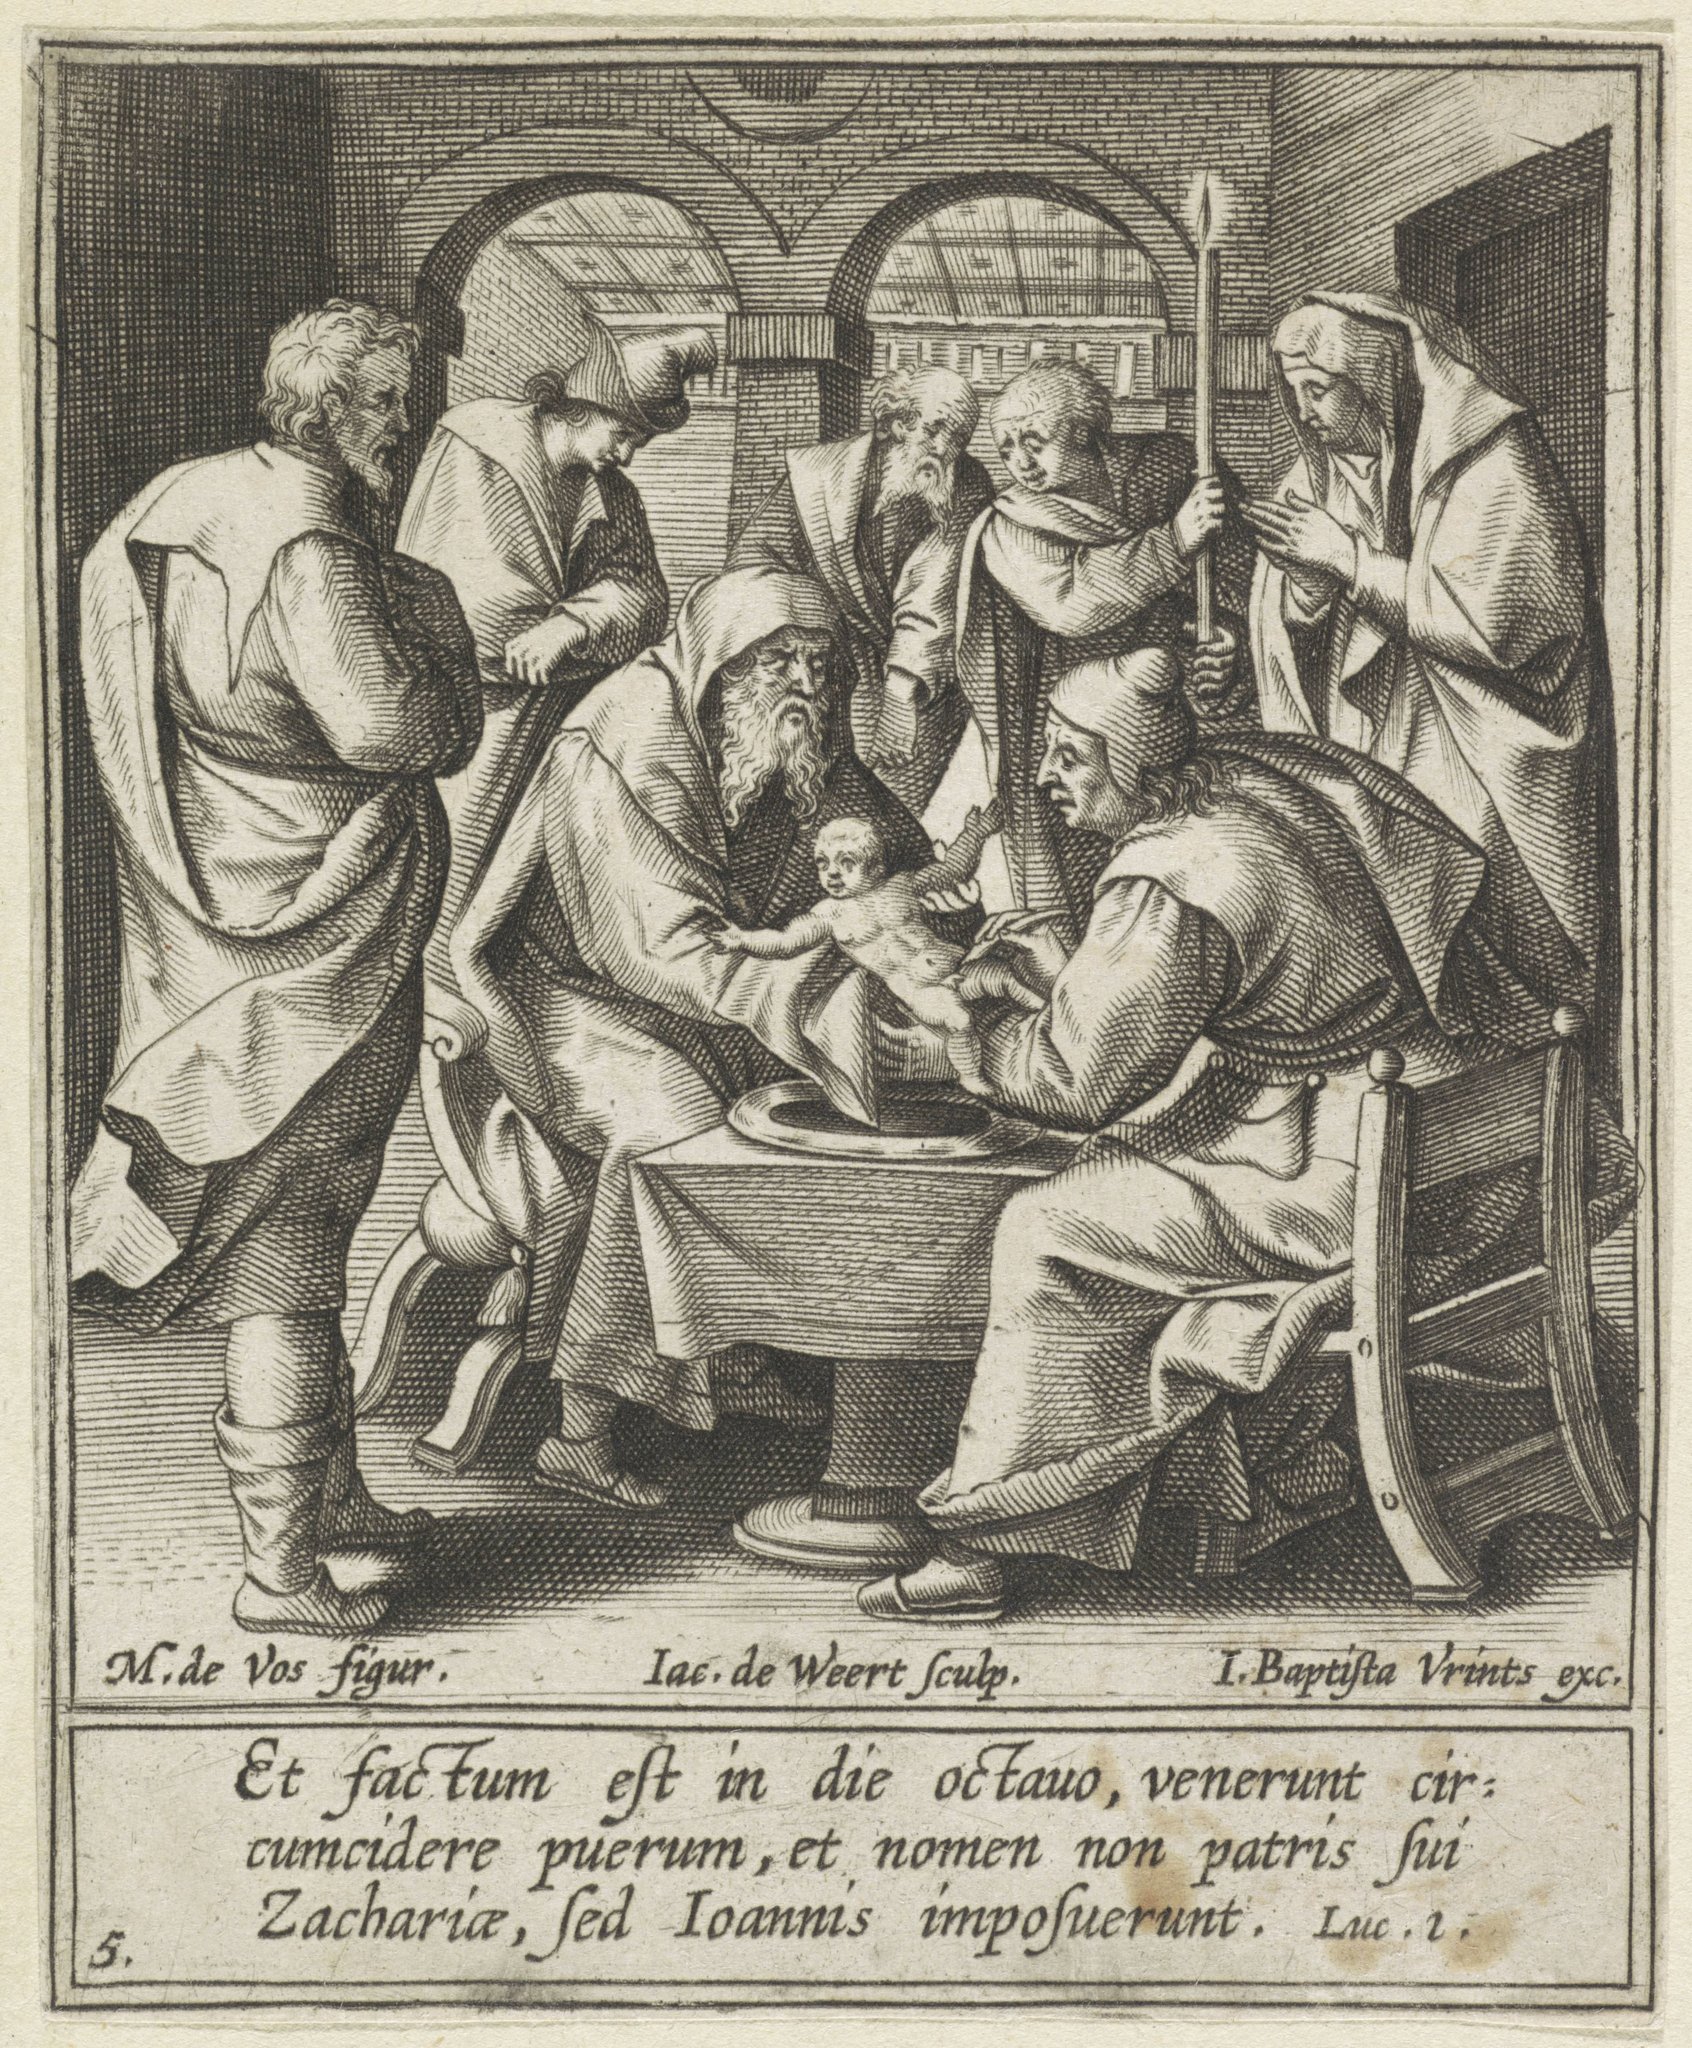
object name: print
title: Leven van Johannes de Doper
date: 1580-1600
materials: paper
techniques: engraving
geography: antwerp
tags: circumcision of john the baptist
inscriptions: collector's mark: Lugt 240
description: Zacharias zit aan tafel en houdt Johannes de Doper vast boven een schaal. De man tegenover hem besnijdt hem. Enkele mannen en Elisabet kijken staand toe. Eén van hen draagt een brandende fakkel. Onder de voorstelling bevindt zich een drieregelige, Latijnse tekst met de beschrijving van de scène uit Luc. 1.